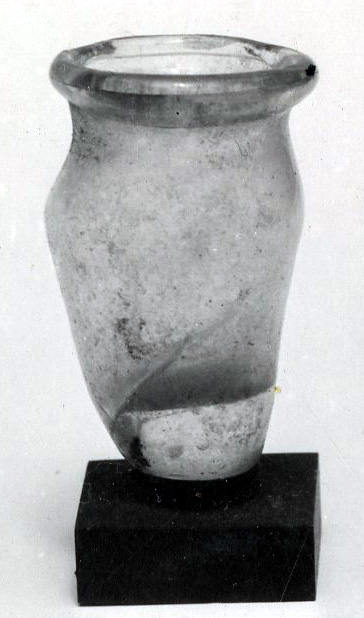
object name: bottle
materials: glass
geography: egypt